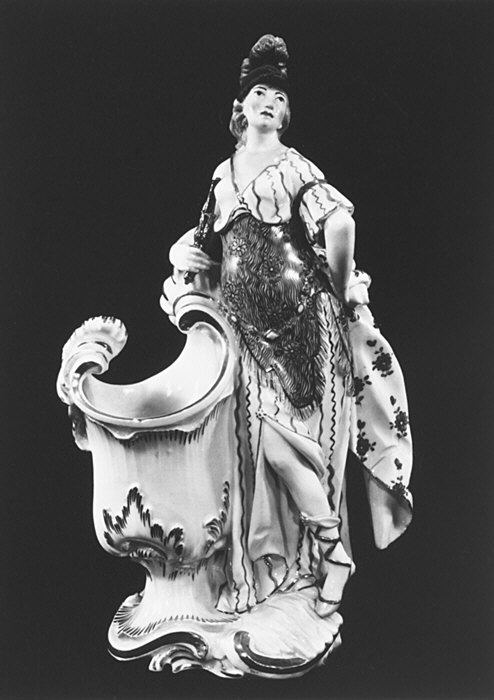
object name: figure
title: Europe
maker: frankenthal porcelain manufactory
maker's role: manufactory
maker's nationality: german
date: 1765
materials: hard paste porcelain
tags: europa